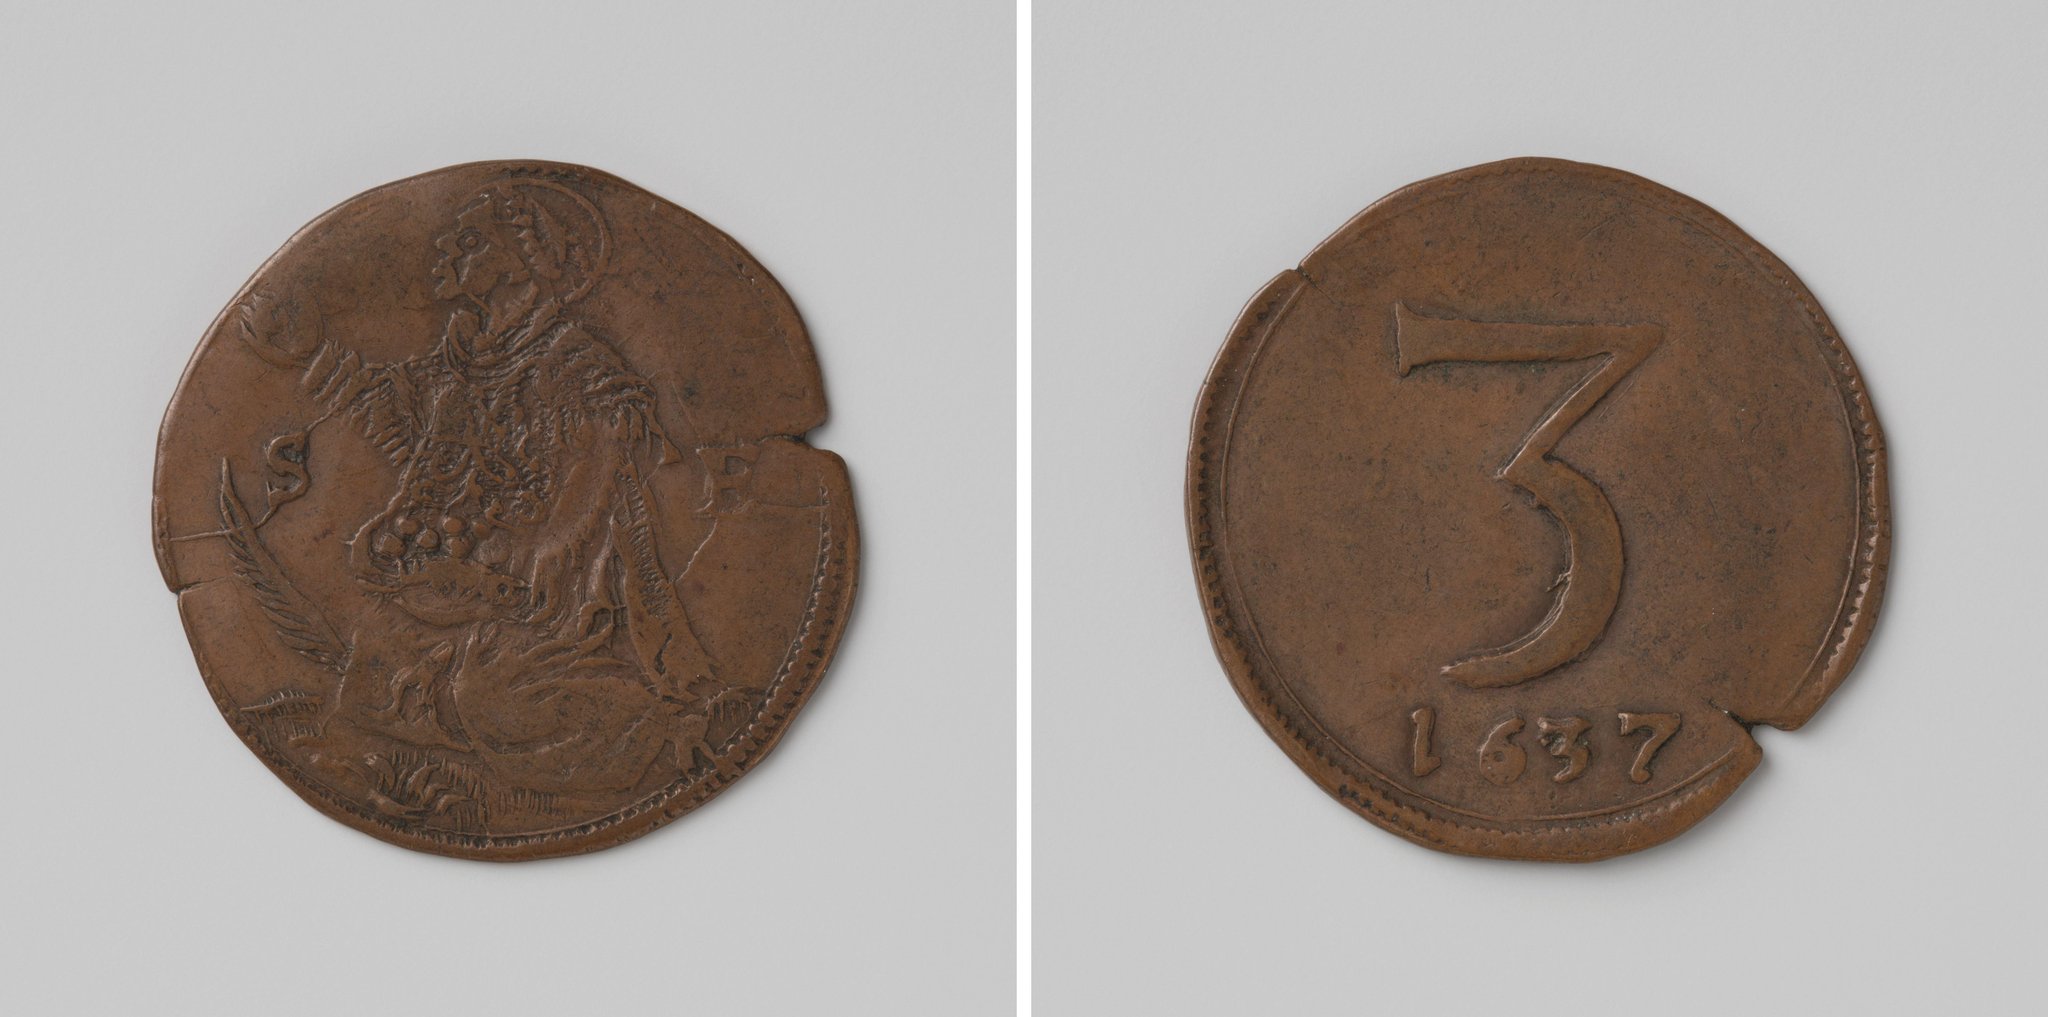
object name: devotional medal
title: Religieuze penning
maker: Anonymous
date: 1637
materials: copper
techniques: striking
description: Koperen penning. Voorzijde: naar links gewende, geknielde heilige met aureool en geheven rechterhand, tussen letters S en E. Keerzijde: cijfer 3 boven jaartal. Vermoedelijk een religieuze penning.